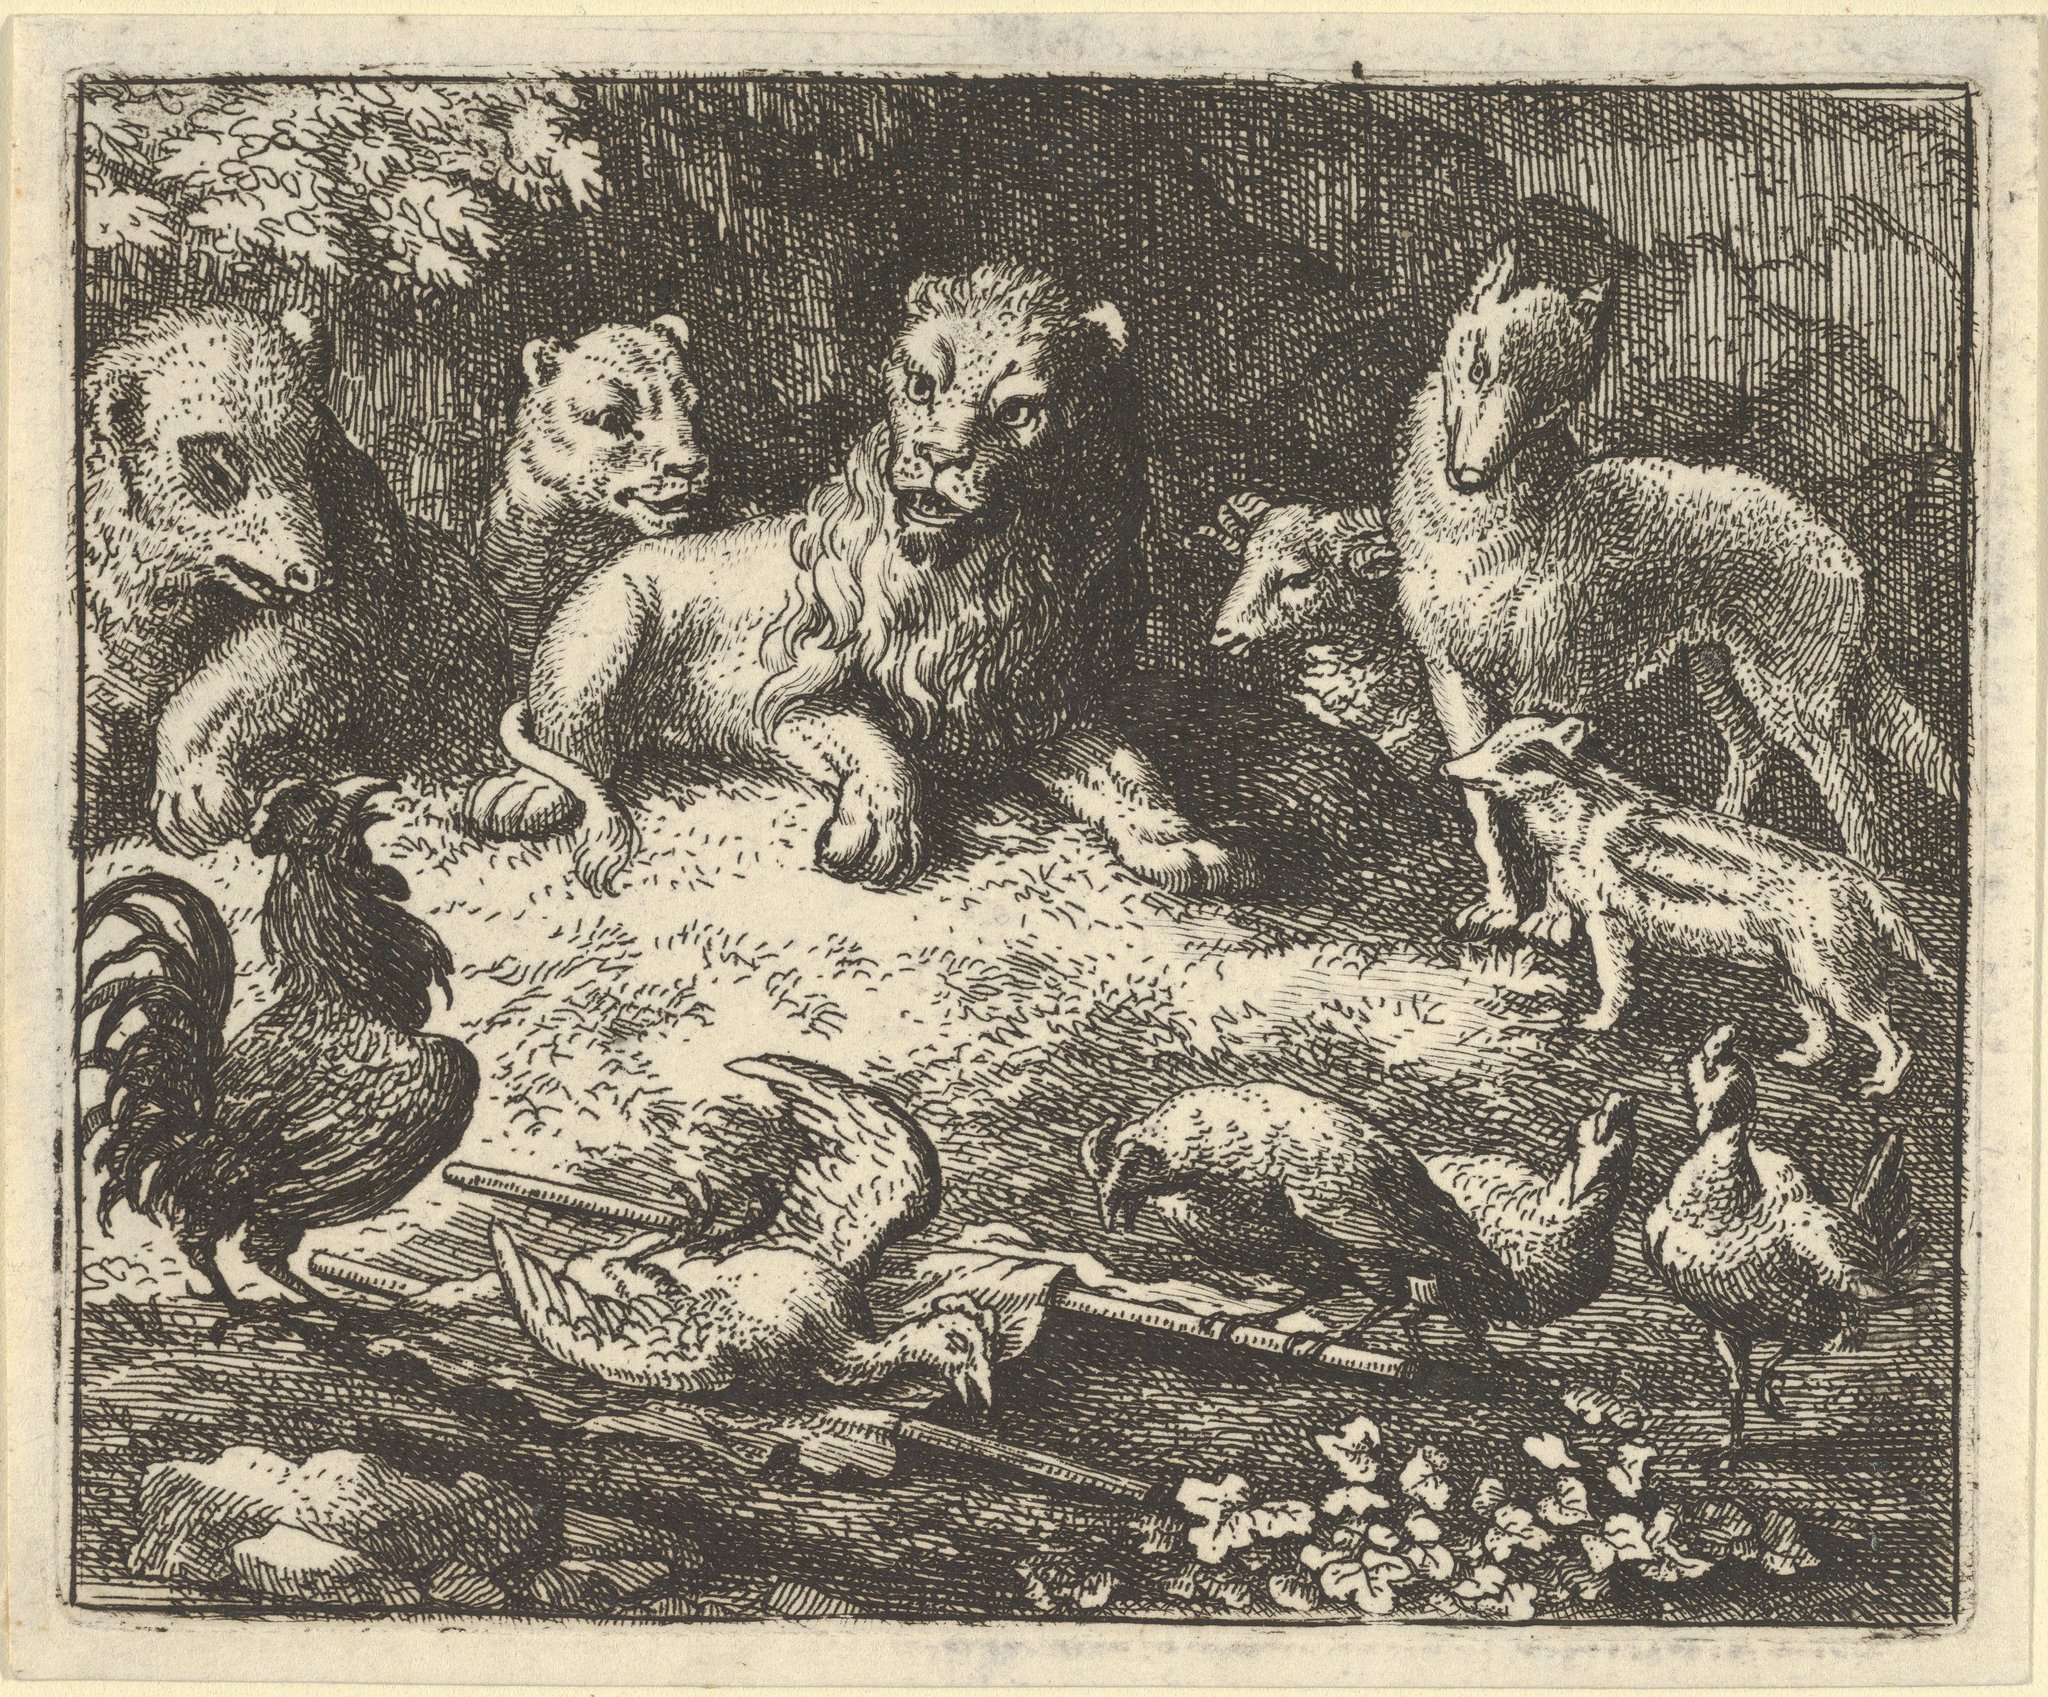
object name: print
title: The Rooster Accuses Renard of Murdering his Chicken from Hendrick van Alcmar's Renard The Fox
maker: allart van everdingen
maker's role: artist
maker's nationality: dutch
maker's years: 1621-1675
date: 1650-1675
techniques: engraving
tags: bears,chickens,roosters,foxes,lions